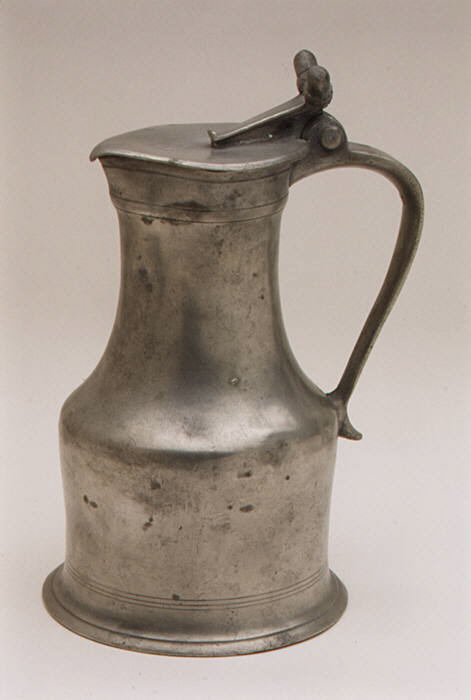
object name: measure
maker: i. ruault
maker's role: maker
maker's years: 1750-1850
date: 1767-1833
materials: pewter